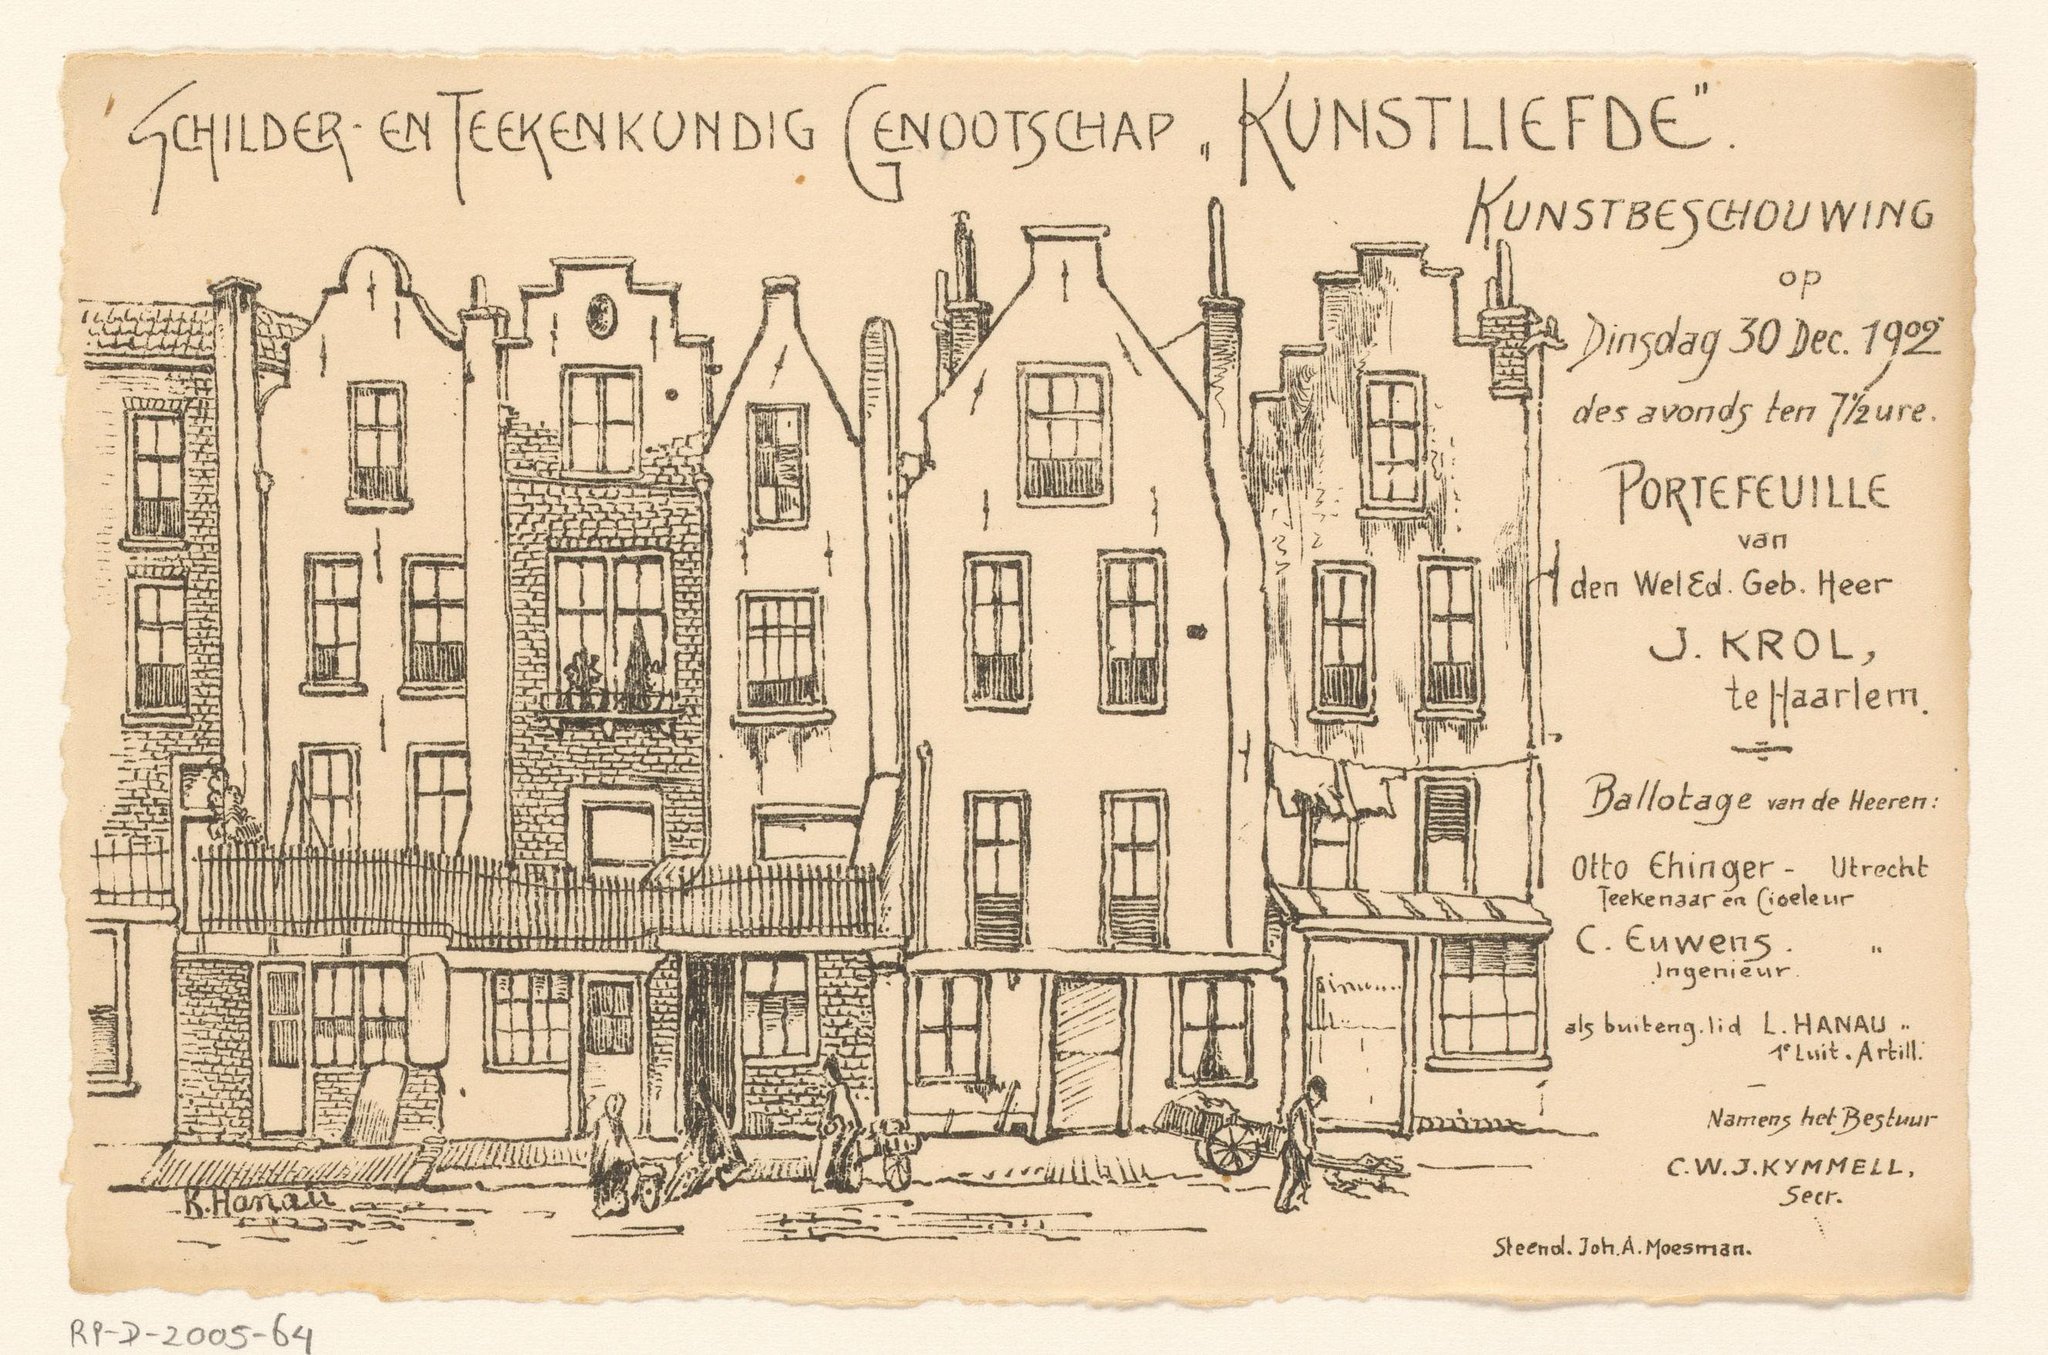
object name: invitation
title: Uitnodiging van Schilder- en Teekenkundig Genootschap "Kunstliefde" voor een kunstbeschouwing, 30 december 1902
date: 1902-1912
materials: paper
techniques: lithograph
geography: utrecht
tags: criticizing and discussing art, art criticism, circle, club of artists, collecting and exhibiting products of the fine arts, public road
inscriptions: collector's mark: Lugt 2228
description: Huizen aan een straat. Uitnodiging van Schilder- en Teekenkundig Genootschap "Kunstliefde" voor een kunstbeschouwing op 30 december 1902 van de portefeuille van dhr. J. Krol te Haarlem.